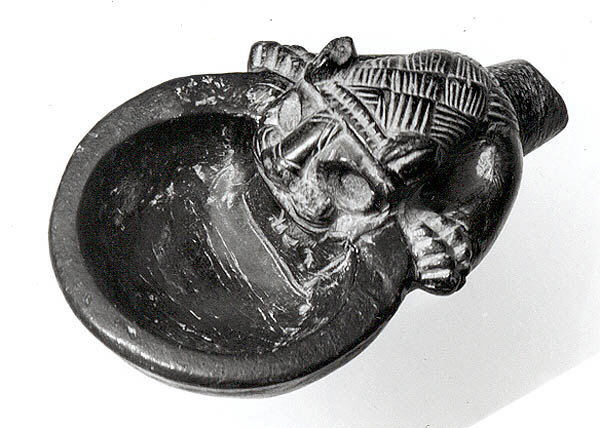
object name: bowl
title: Bowl with a handle in the form of the forepart of a lion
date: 800-701 BCE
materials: mineral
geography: northern syria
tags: lions